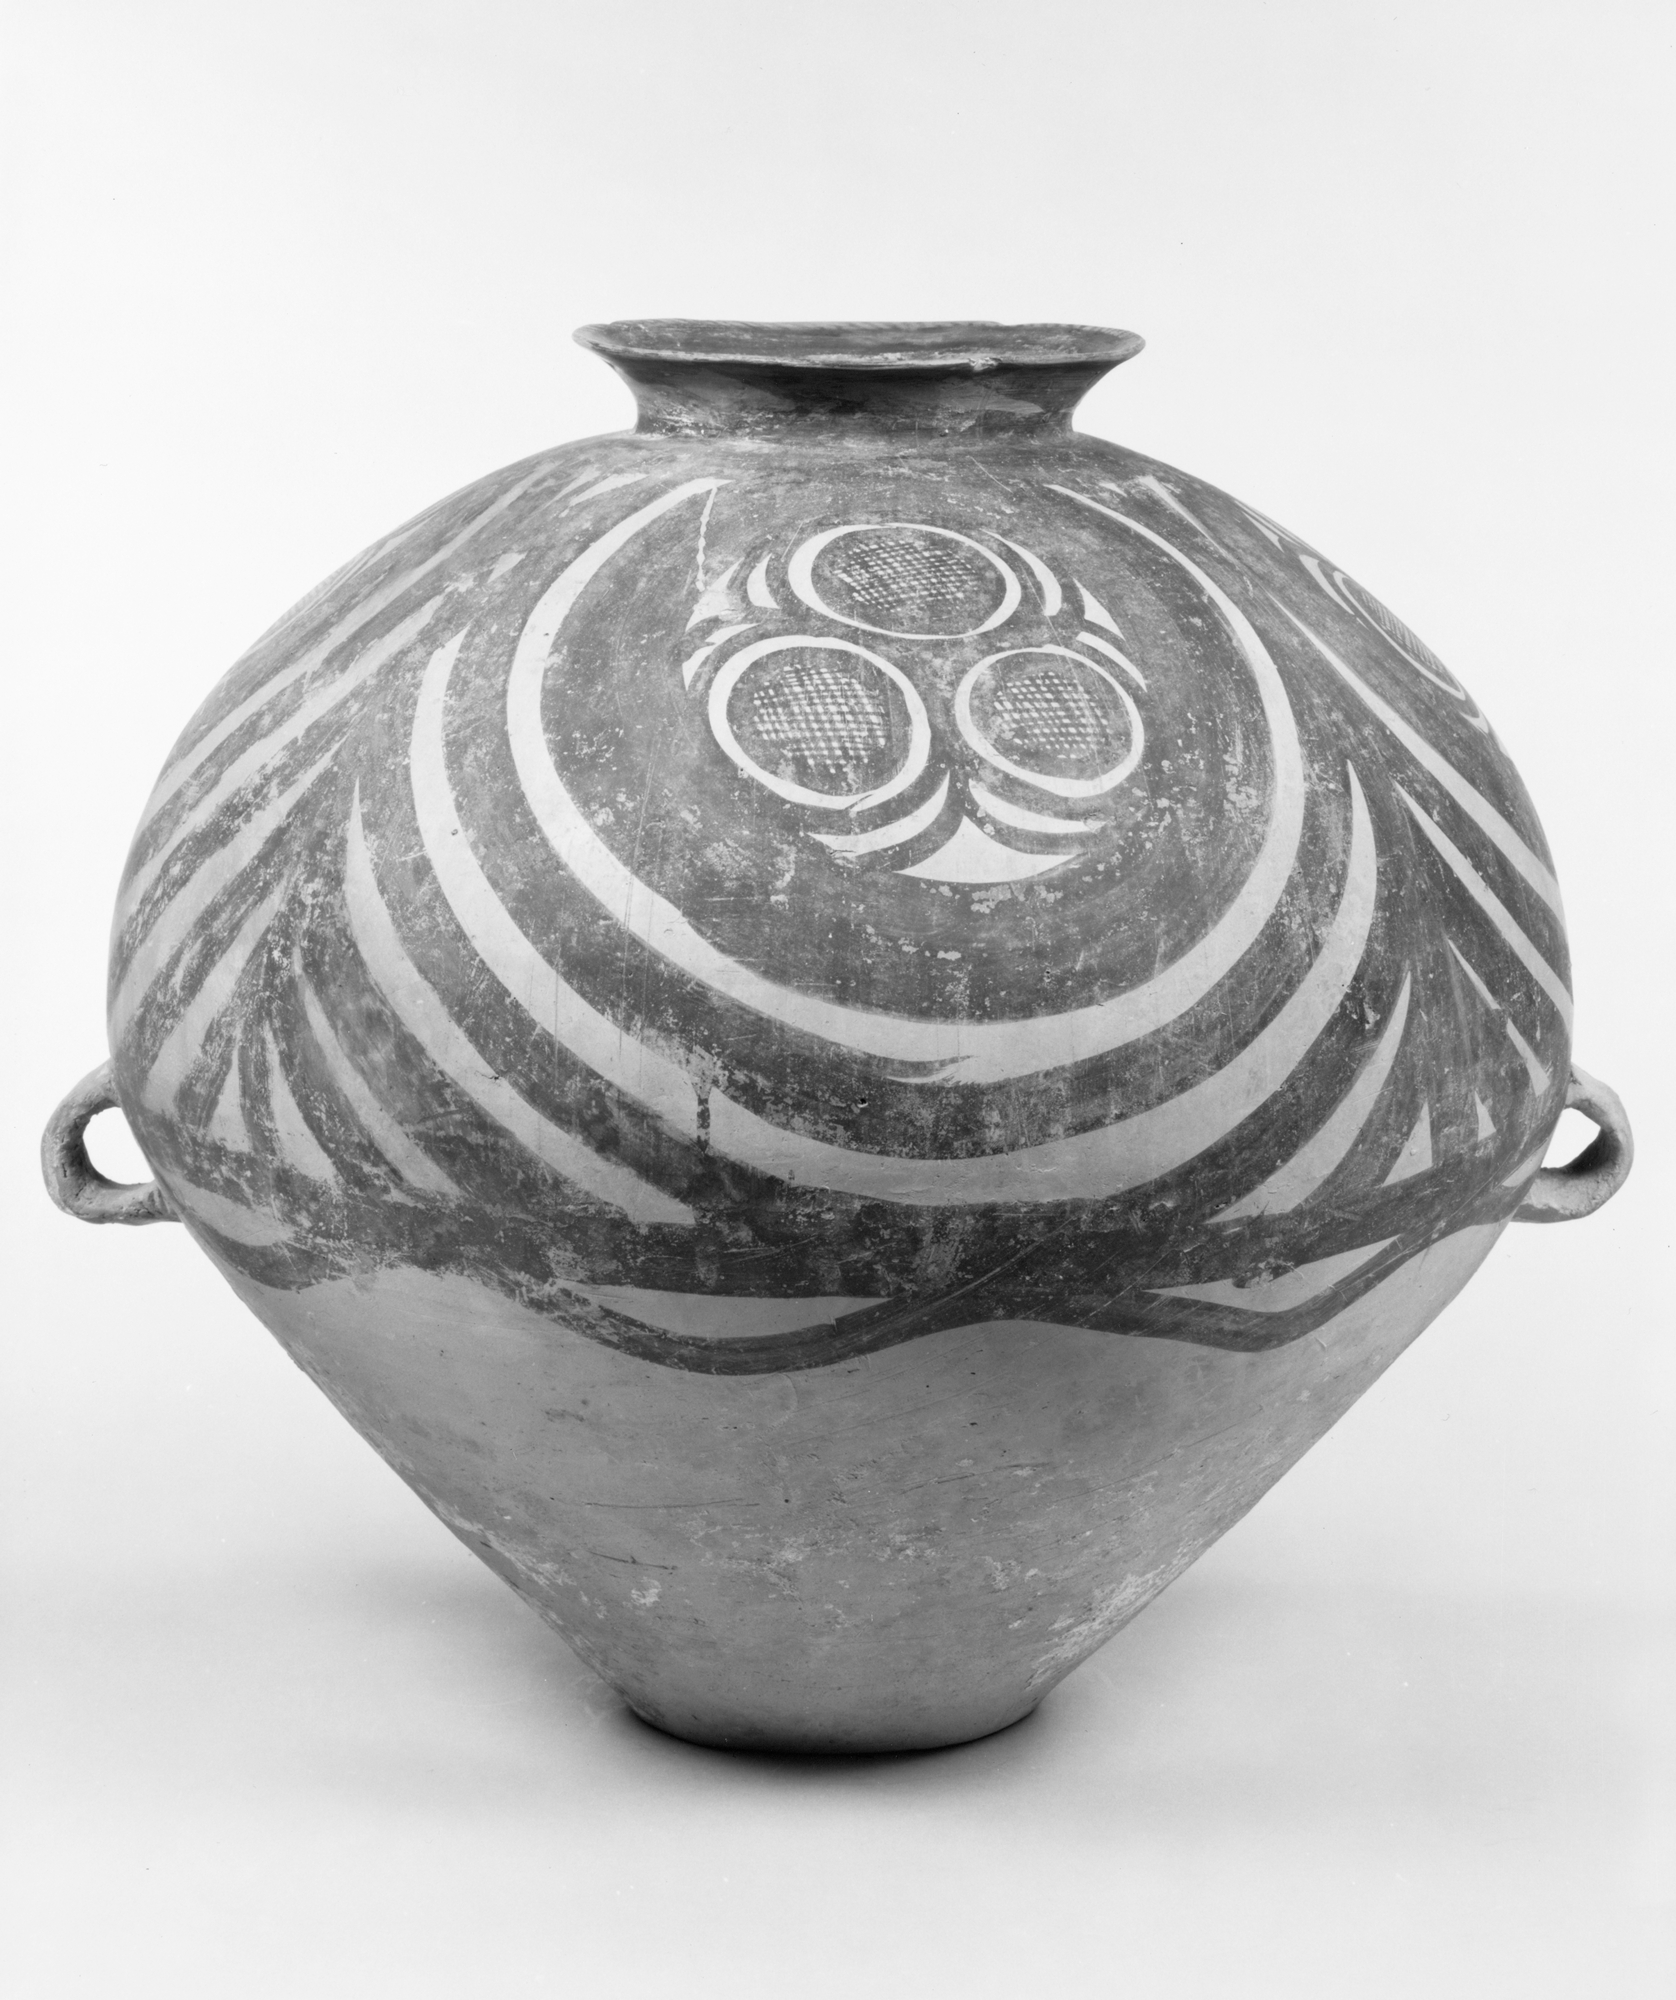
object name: jar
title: Jar (Guan)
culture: chinese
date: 2500-2000 BCE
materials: earthenware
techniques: painting